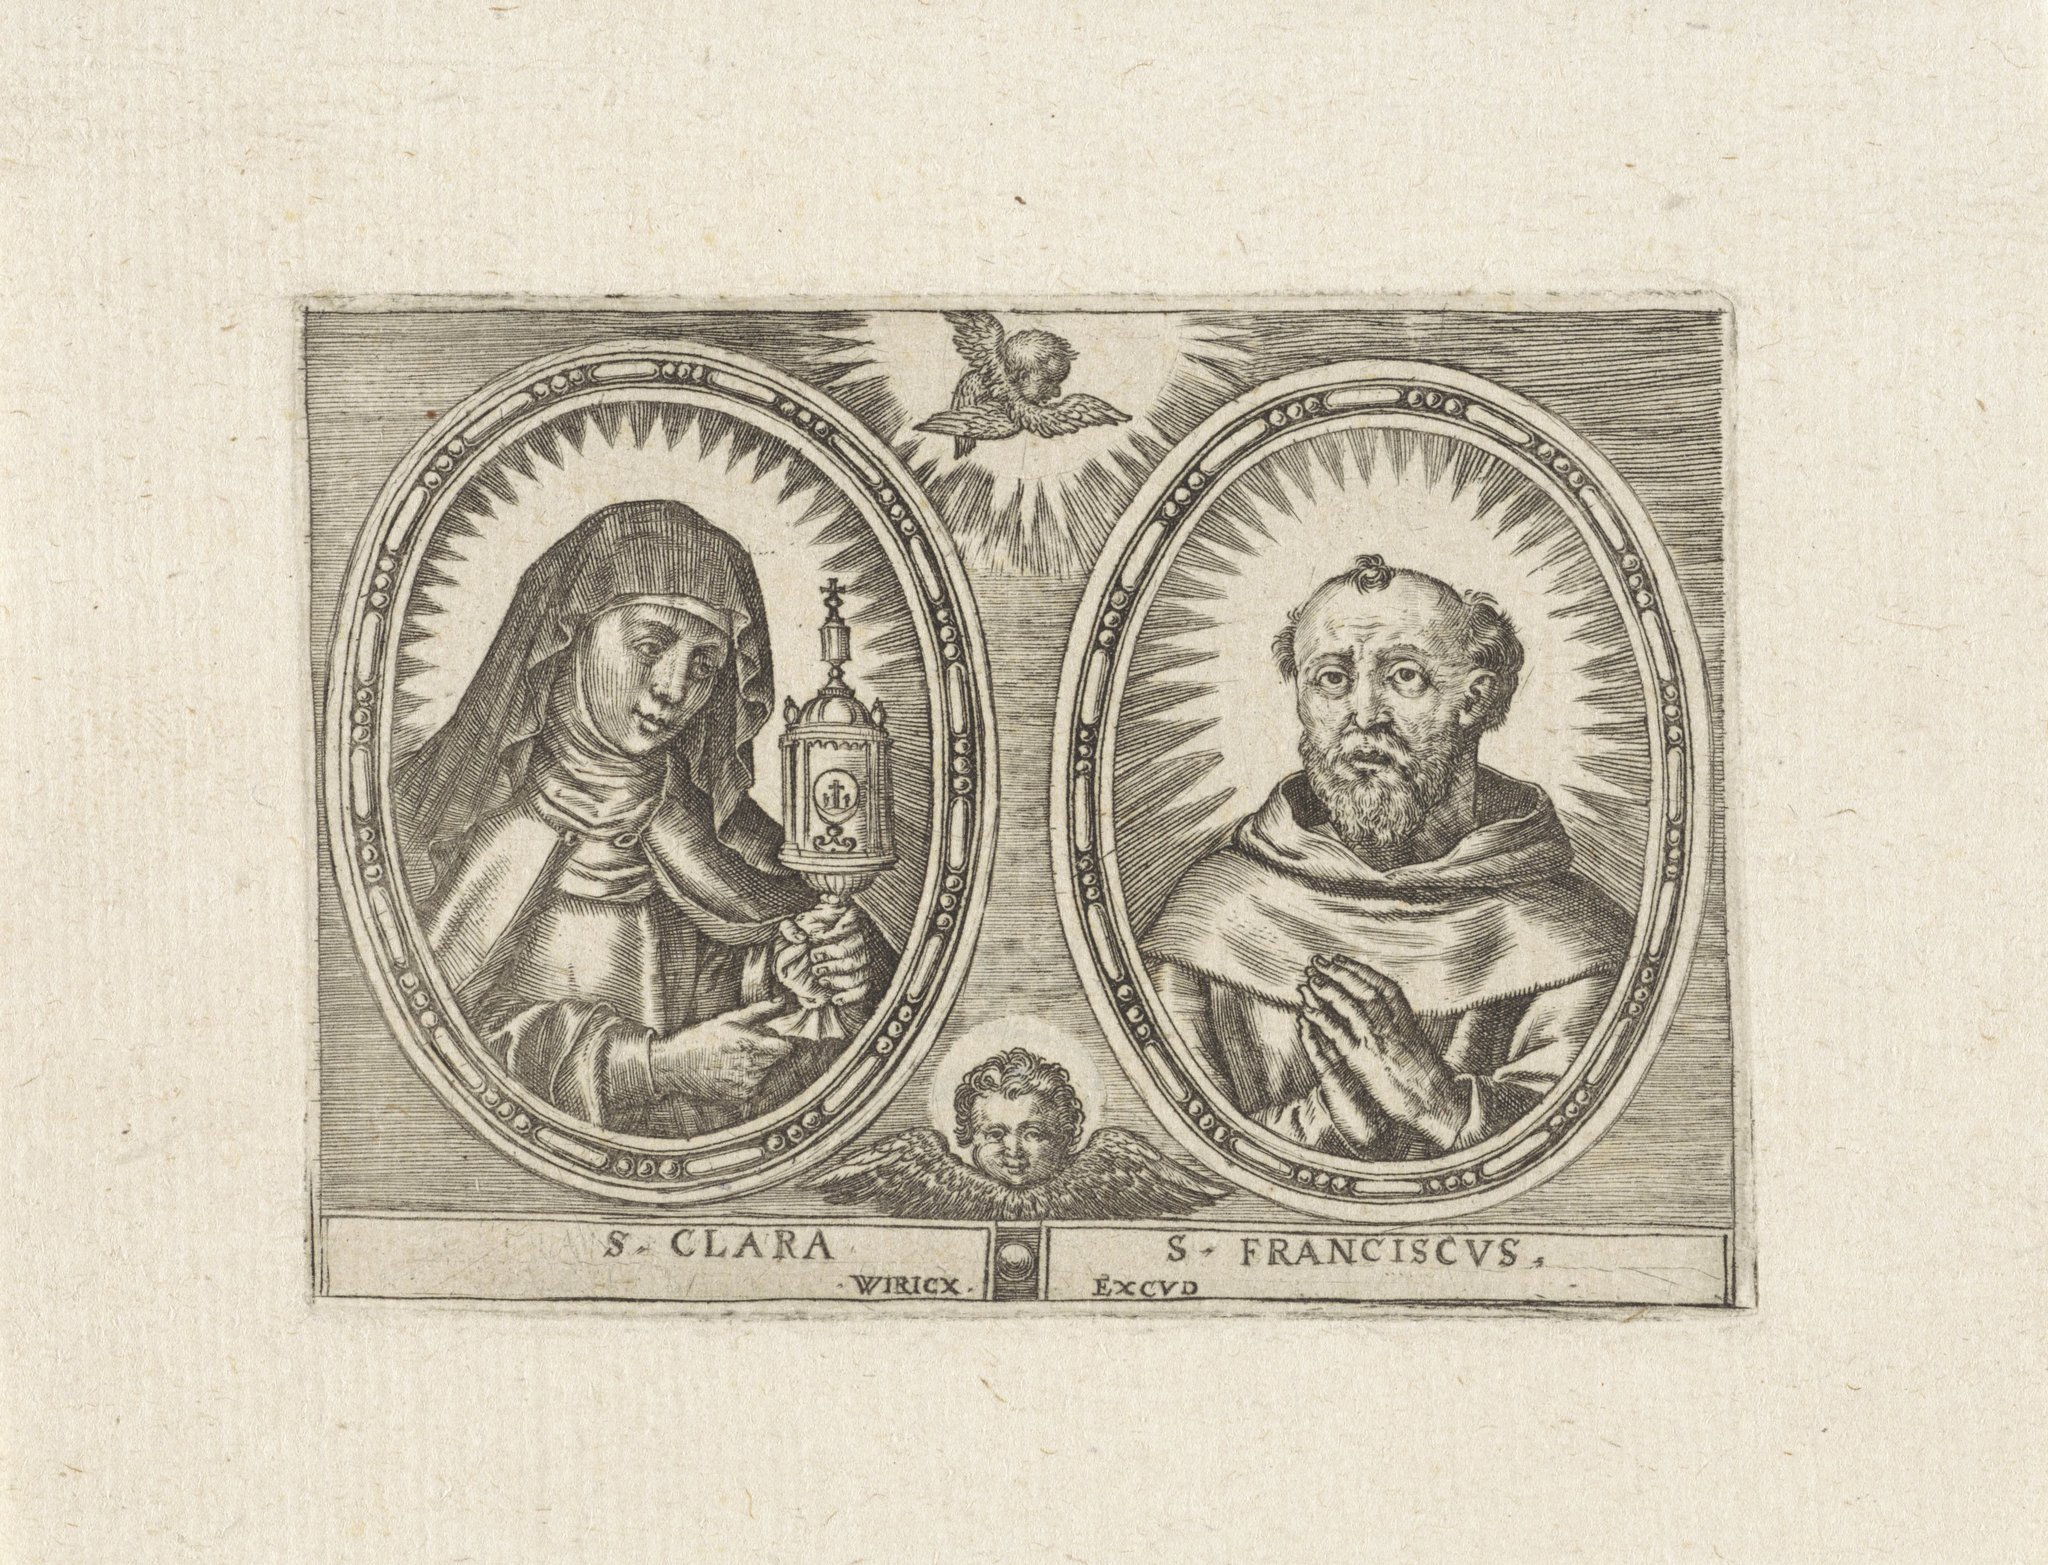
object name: print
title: S. Clara / S. Franciscvs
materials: paper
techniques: engraving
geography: antwerp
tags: cherubs, i.e. children's heads with wings, female saints (clara), founder of the order of friars minor (franciscans), francis(cus) of assisi; possible attributes: book, crucifix, lily, skull, stigmata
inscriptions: collector's mark: Lugt 2228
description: Links: De heilige Clara, in het habijt van haar orde, met een geknoopte monniksgordel en een sluier. Ze houdt een monstrans in de hand, een verwijzing naar haar verdrijving van de Saracenen. Rechts: De heilige Franciscus van Assisi, in het habijt van zijn orde, met de handen gevouwen in gebed. De voorstellingen zijn gevat in ovale omlijstingen, daartussen twee cherubijnen.